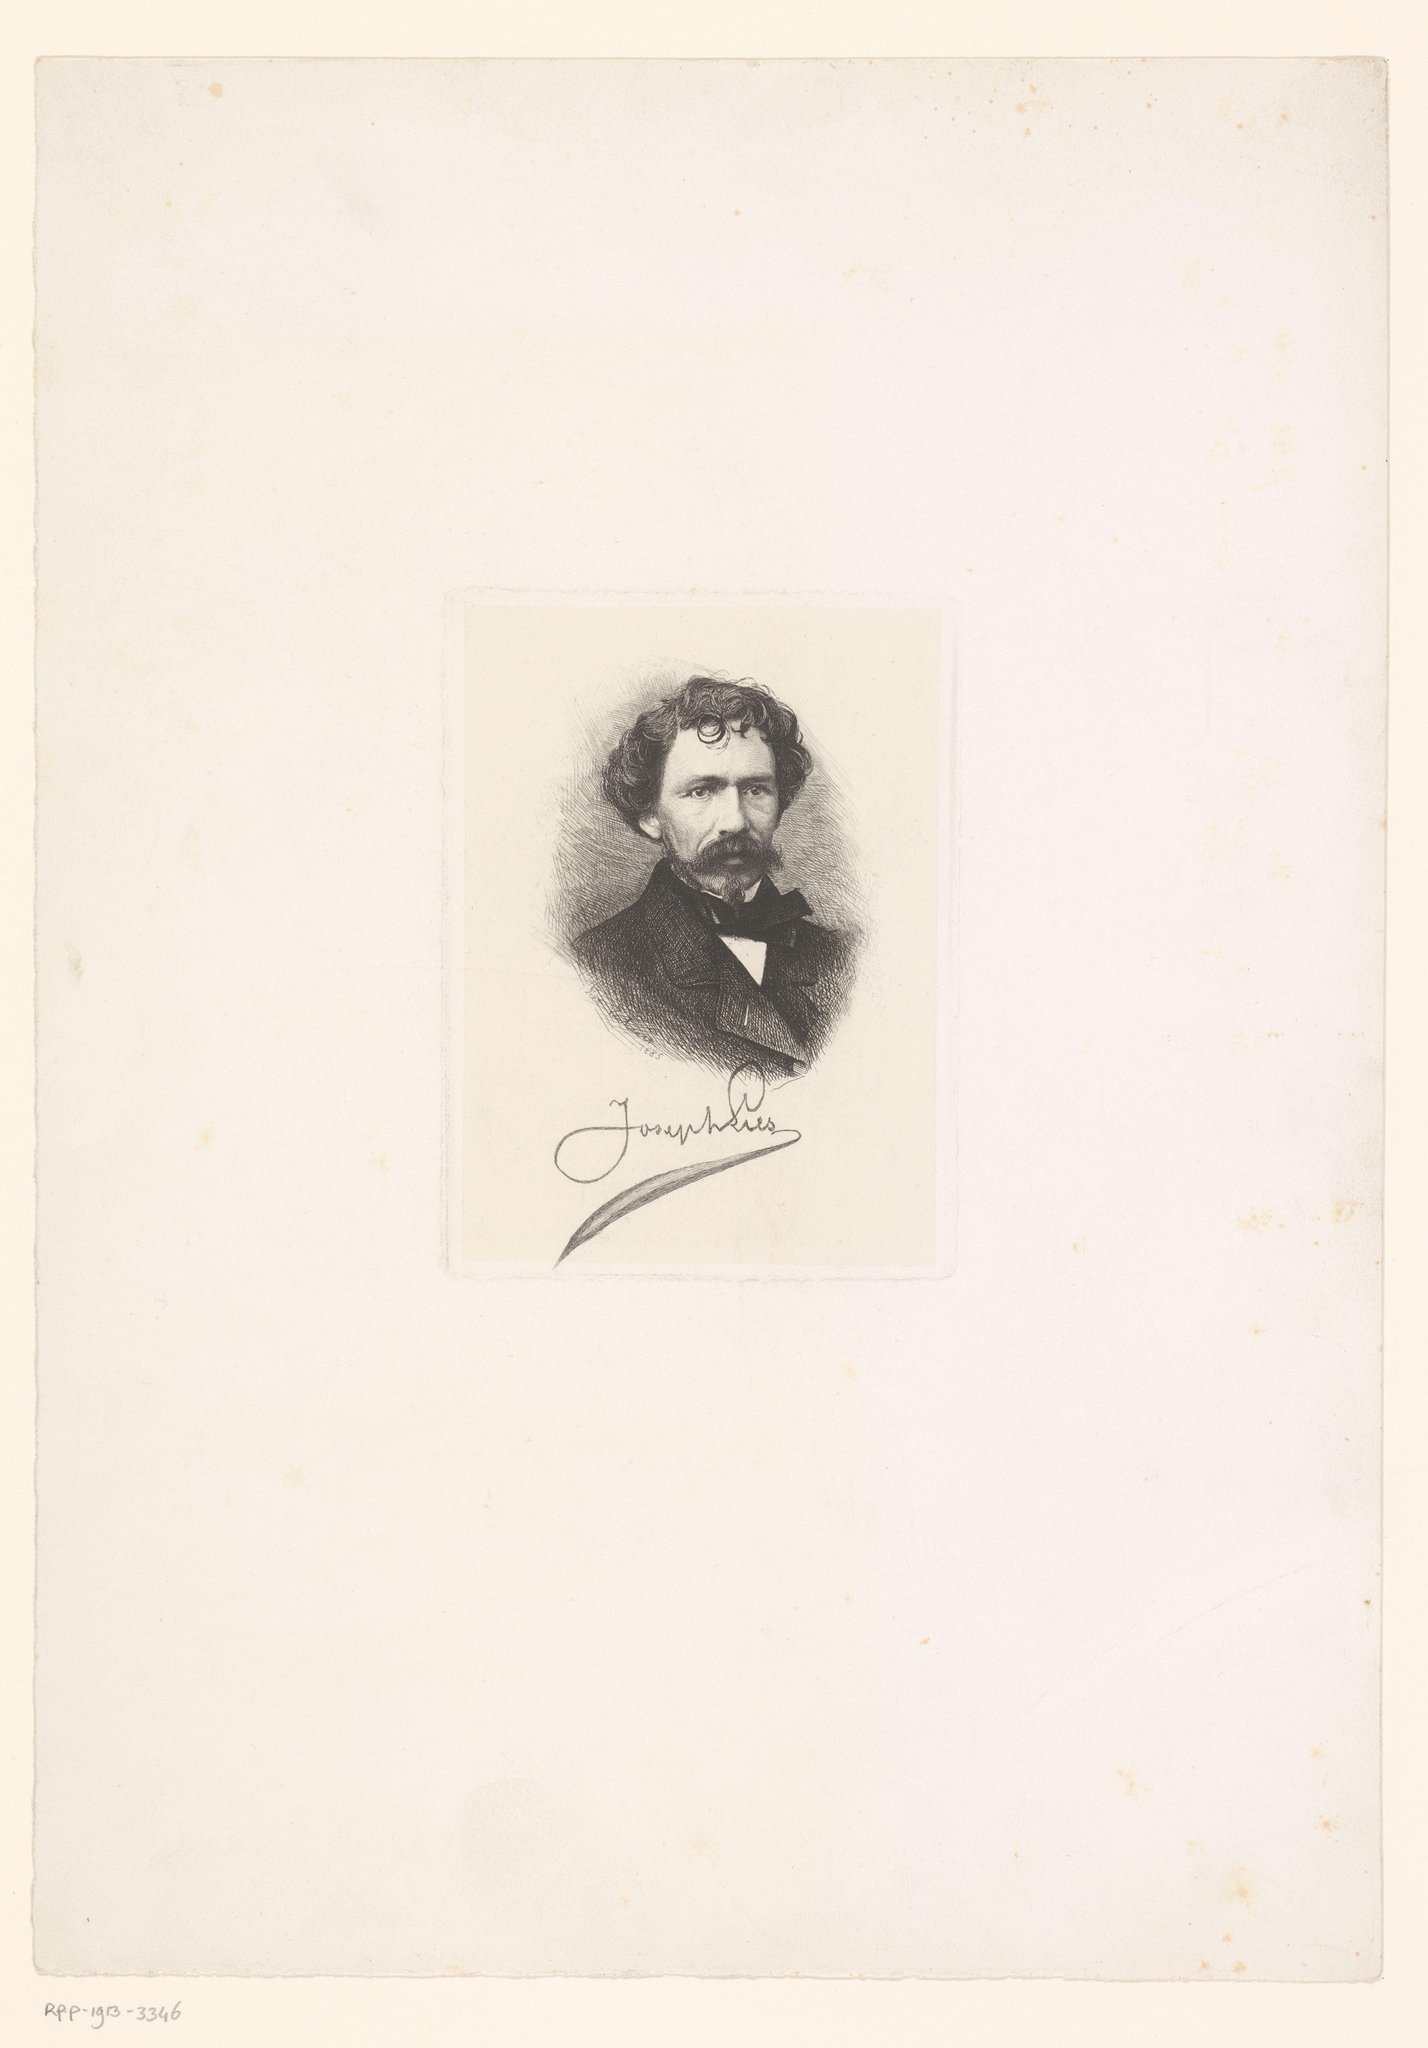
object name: print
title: Joseph Lies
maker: piet verhaert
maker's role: print maker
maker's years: 1852-1908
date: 1885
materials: paper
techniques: etching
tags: antwerp, painter, print maker, joseph lies, adult man, historical persons, beard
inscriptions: collector's mark: Lugt 2228